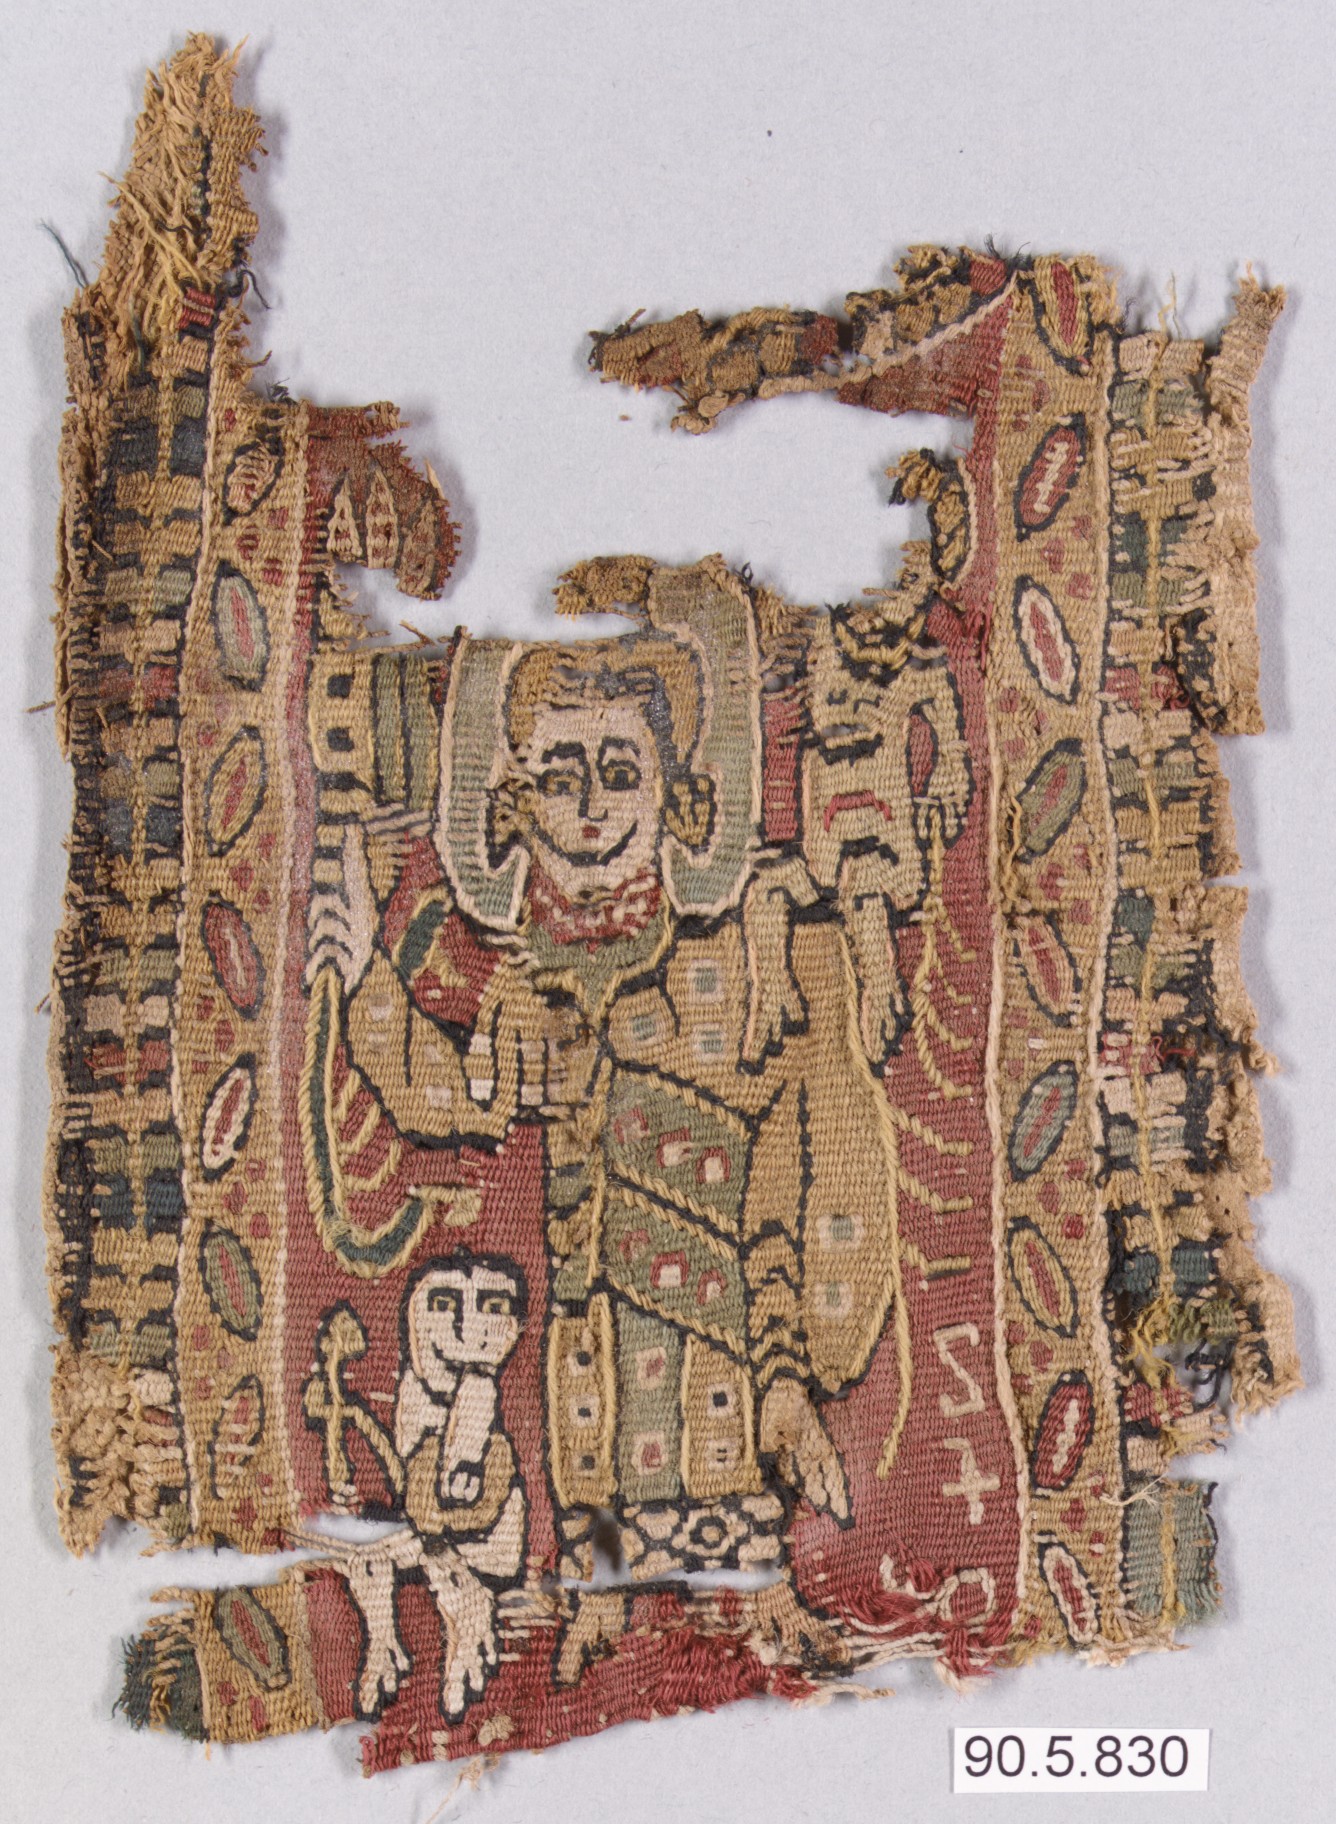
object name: shoulder band fragment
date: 601-800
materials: linen, wool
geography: egypt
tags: human figures